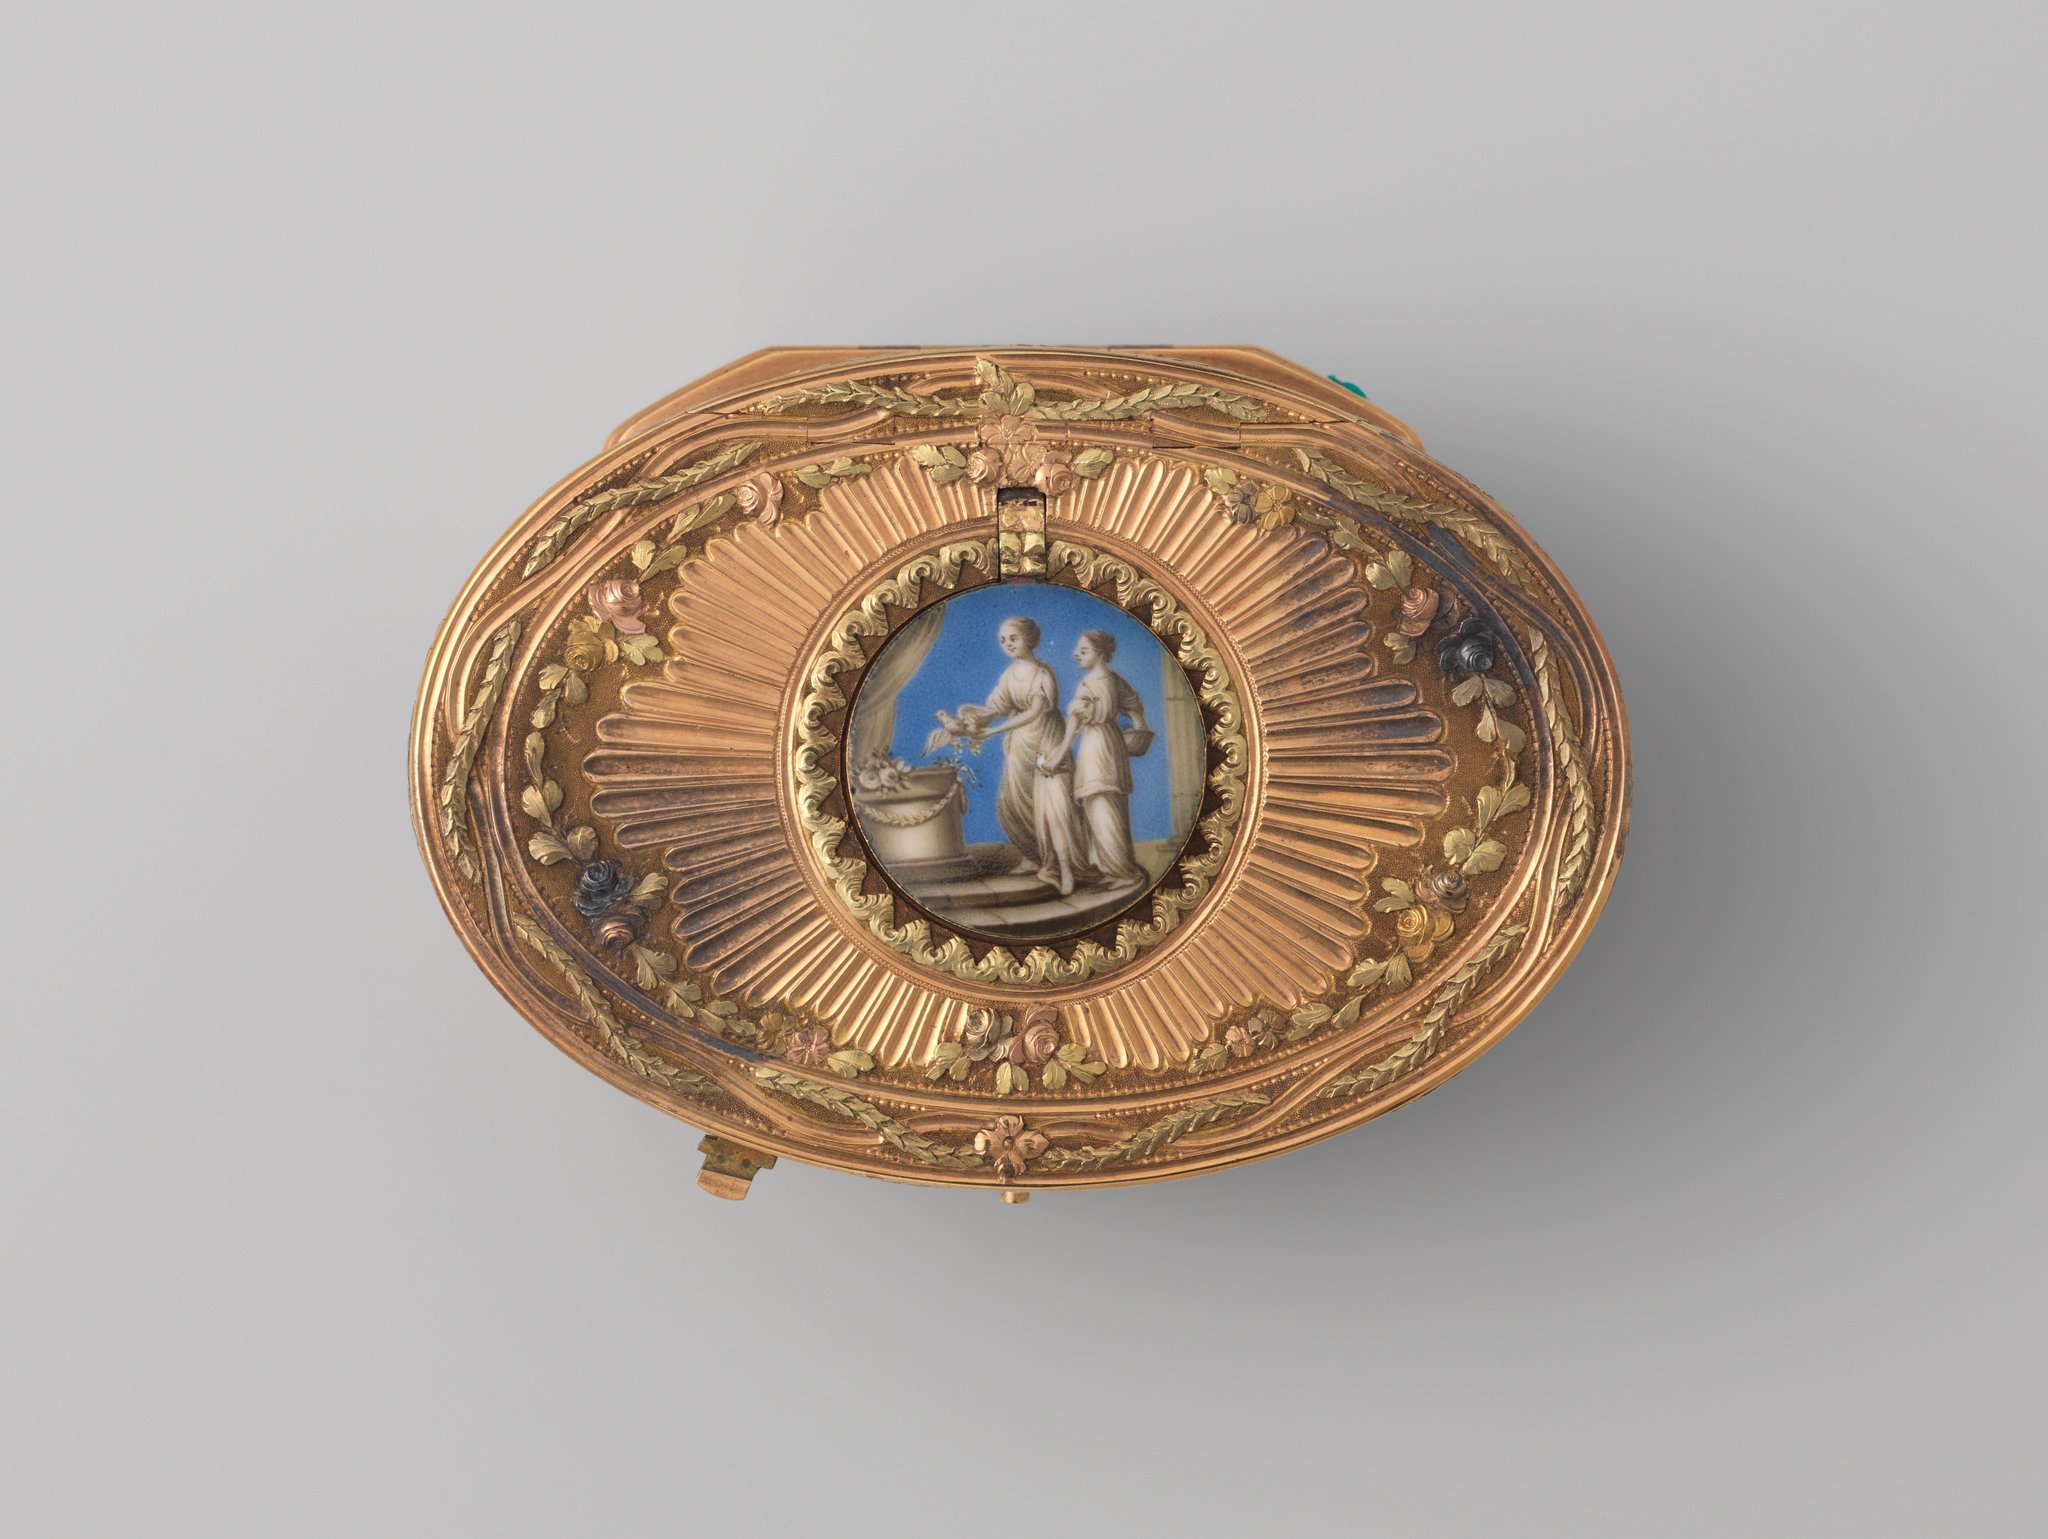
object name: box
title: Ovale snuifdoos van goud, met geëmailleerde miniatuur op het deksel en geciseleerde Lodewijk XVI ornamenten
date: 1770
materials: gold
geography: switzerland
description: Ovale snuifdoos in drie kleuren goud, geheel versierd met geciseleerde randen en ornamenten in de stijl van Lod. XVI. Op het deksel een geëmailleerde miniatuurtje met een voorstelling van twee vrouwen offerend op het altaar der liefde. Van binnen opengewerkt. Gemerkt.